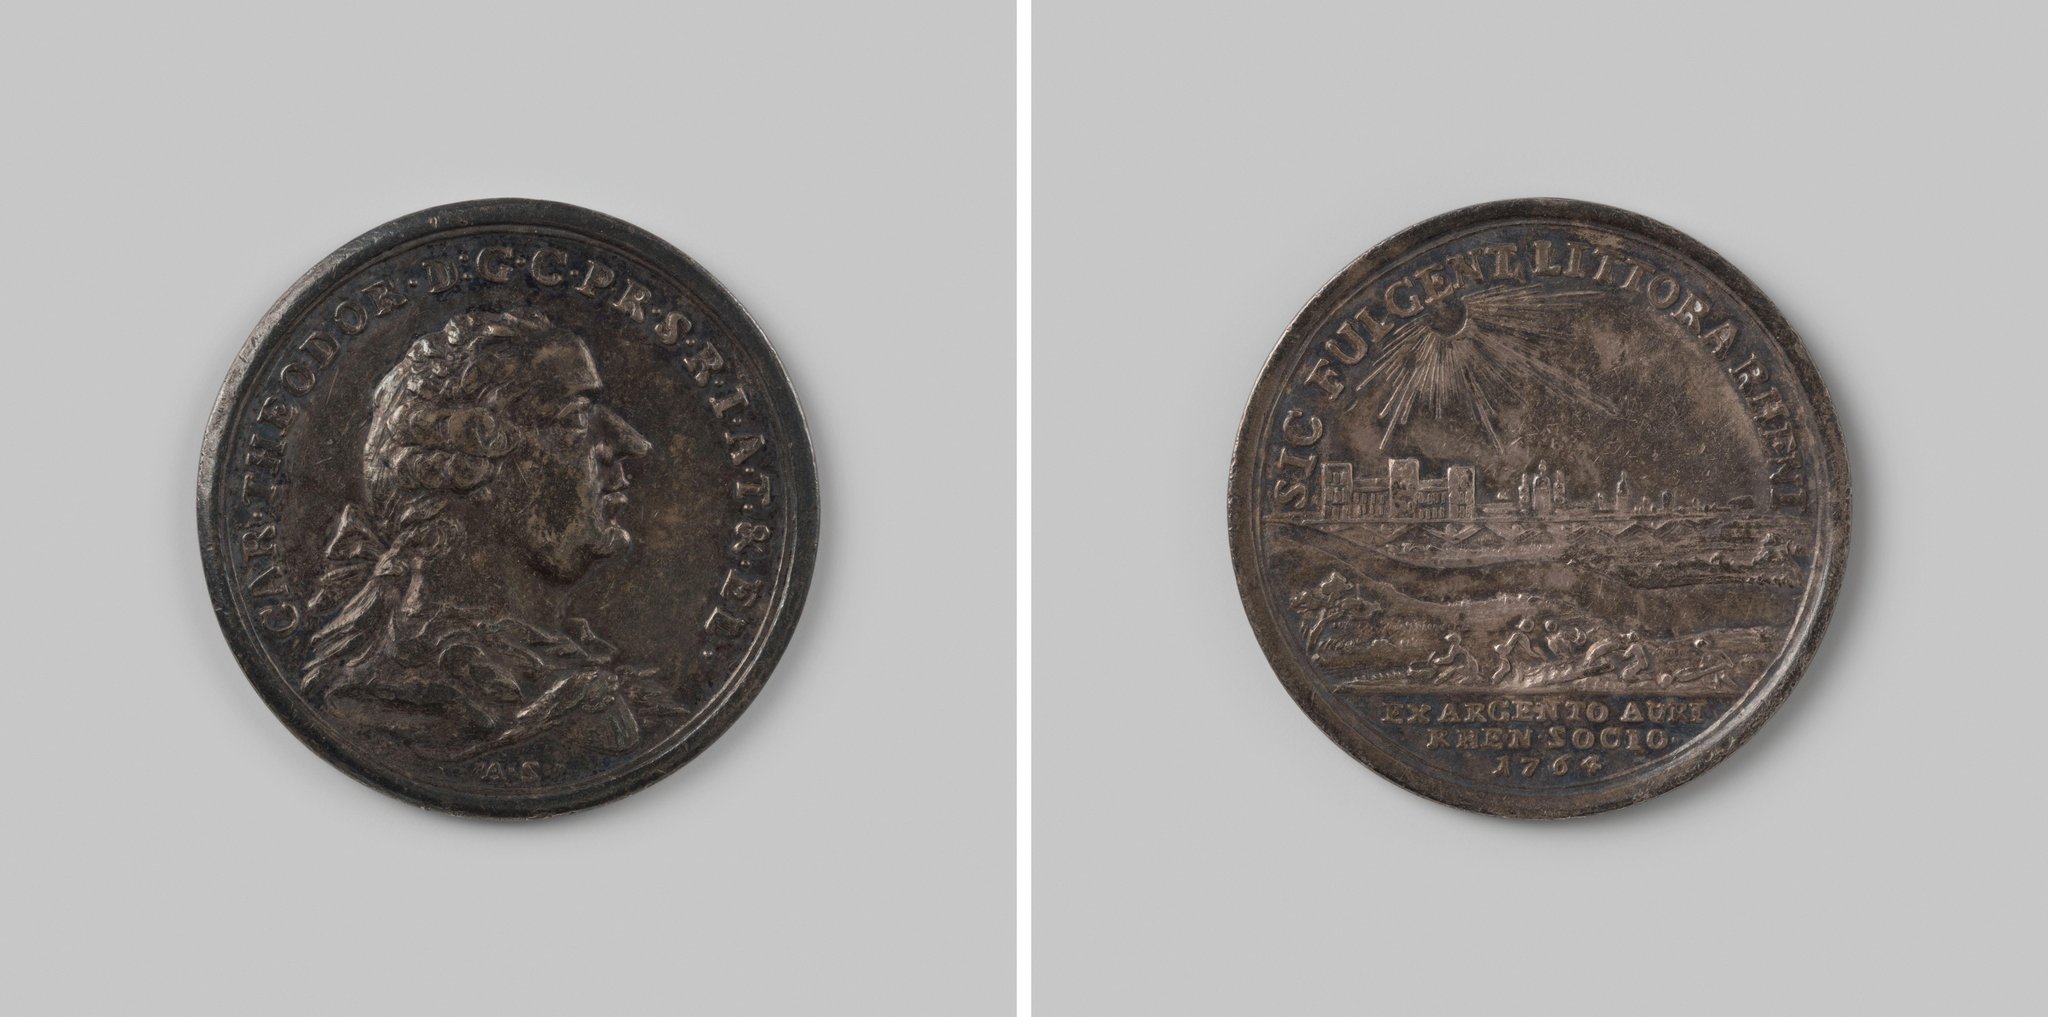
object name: insignia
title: Penning uit Beieren gemaakt van Rijnzilver 1764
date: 1764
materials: silver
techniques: striking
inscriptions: circumscription: ‘SIC FULGENT LITTORA RHENI’, signature: ‘A. S.’, inscription: ‘EX ARGENTO AURI / RHEN. SOCIO. / 1764’, circumscription: ‘CAR. THEODOR. D. G. C. PR. S. R. I. A. T. & EL.’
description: Zilveren penning, op de voorzijde het borstbeeldt van Karel Theodoor van Beieren naar rechts met omschrift, op de keerzijde een zonbeschenen landschap met de Rijn bij Mannheim met goudwassers, met omschrift en afsnedetekst.